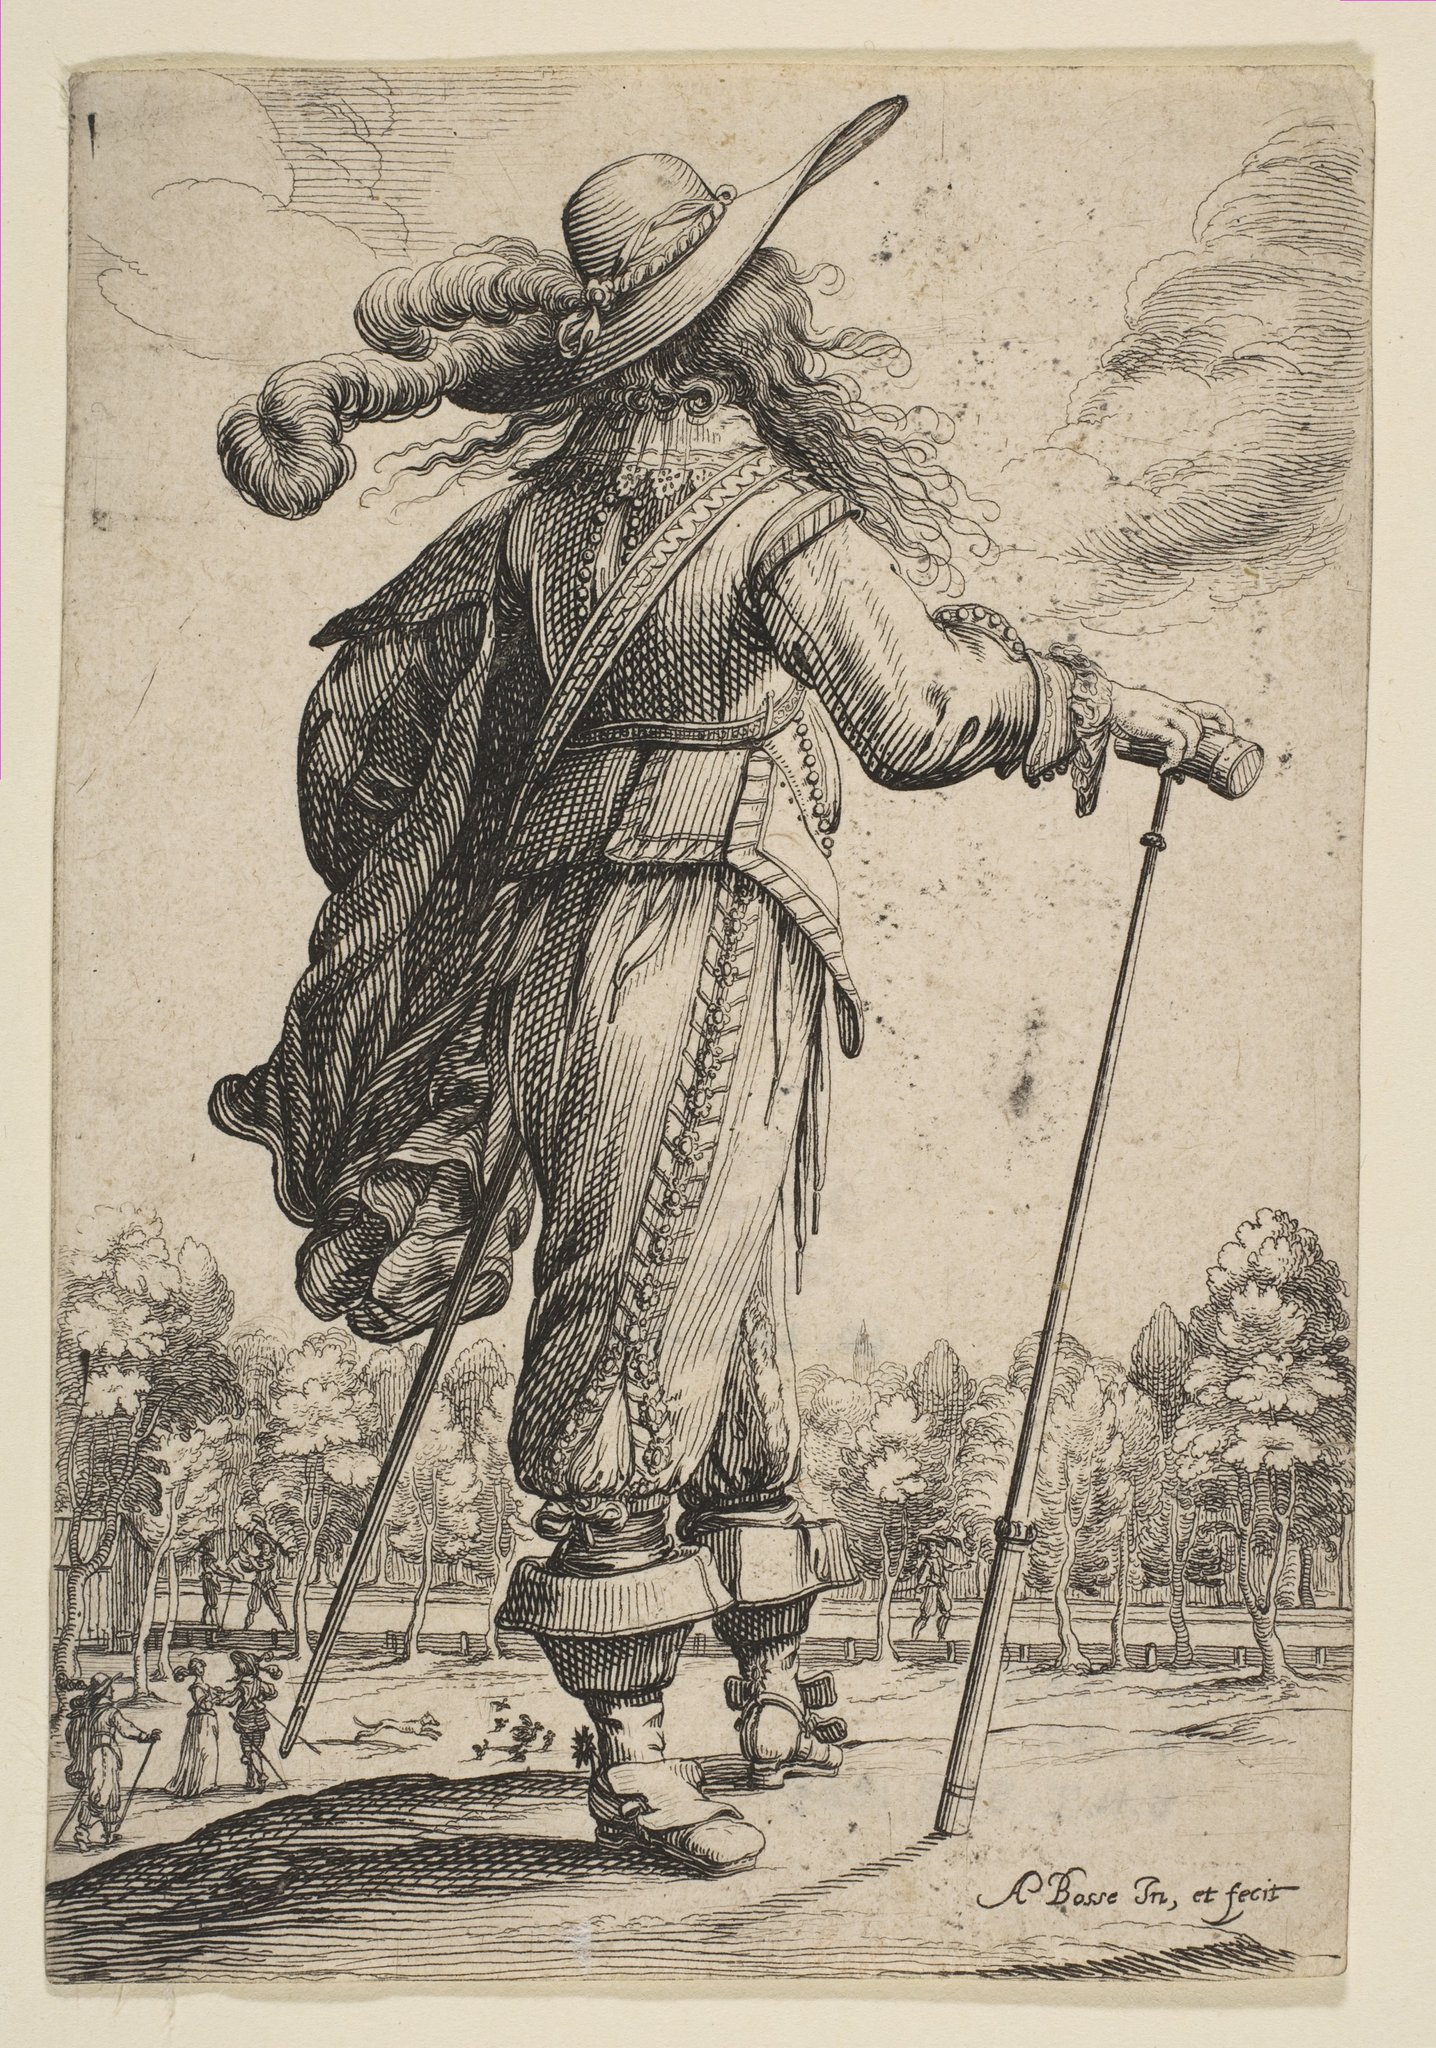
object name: print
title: A Man Seen from the Back Leaning on a Croquet Mallet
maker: abraham bosse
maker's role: artist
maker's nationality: french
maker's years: 1602-1676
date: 1629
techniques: etching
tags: men